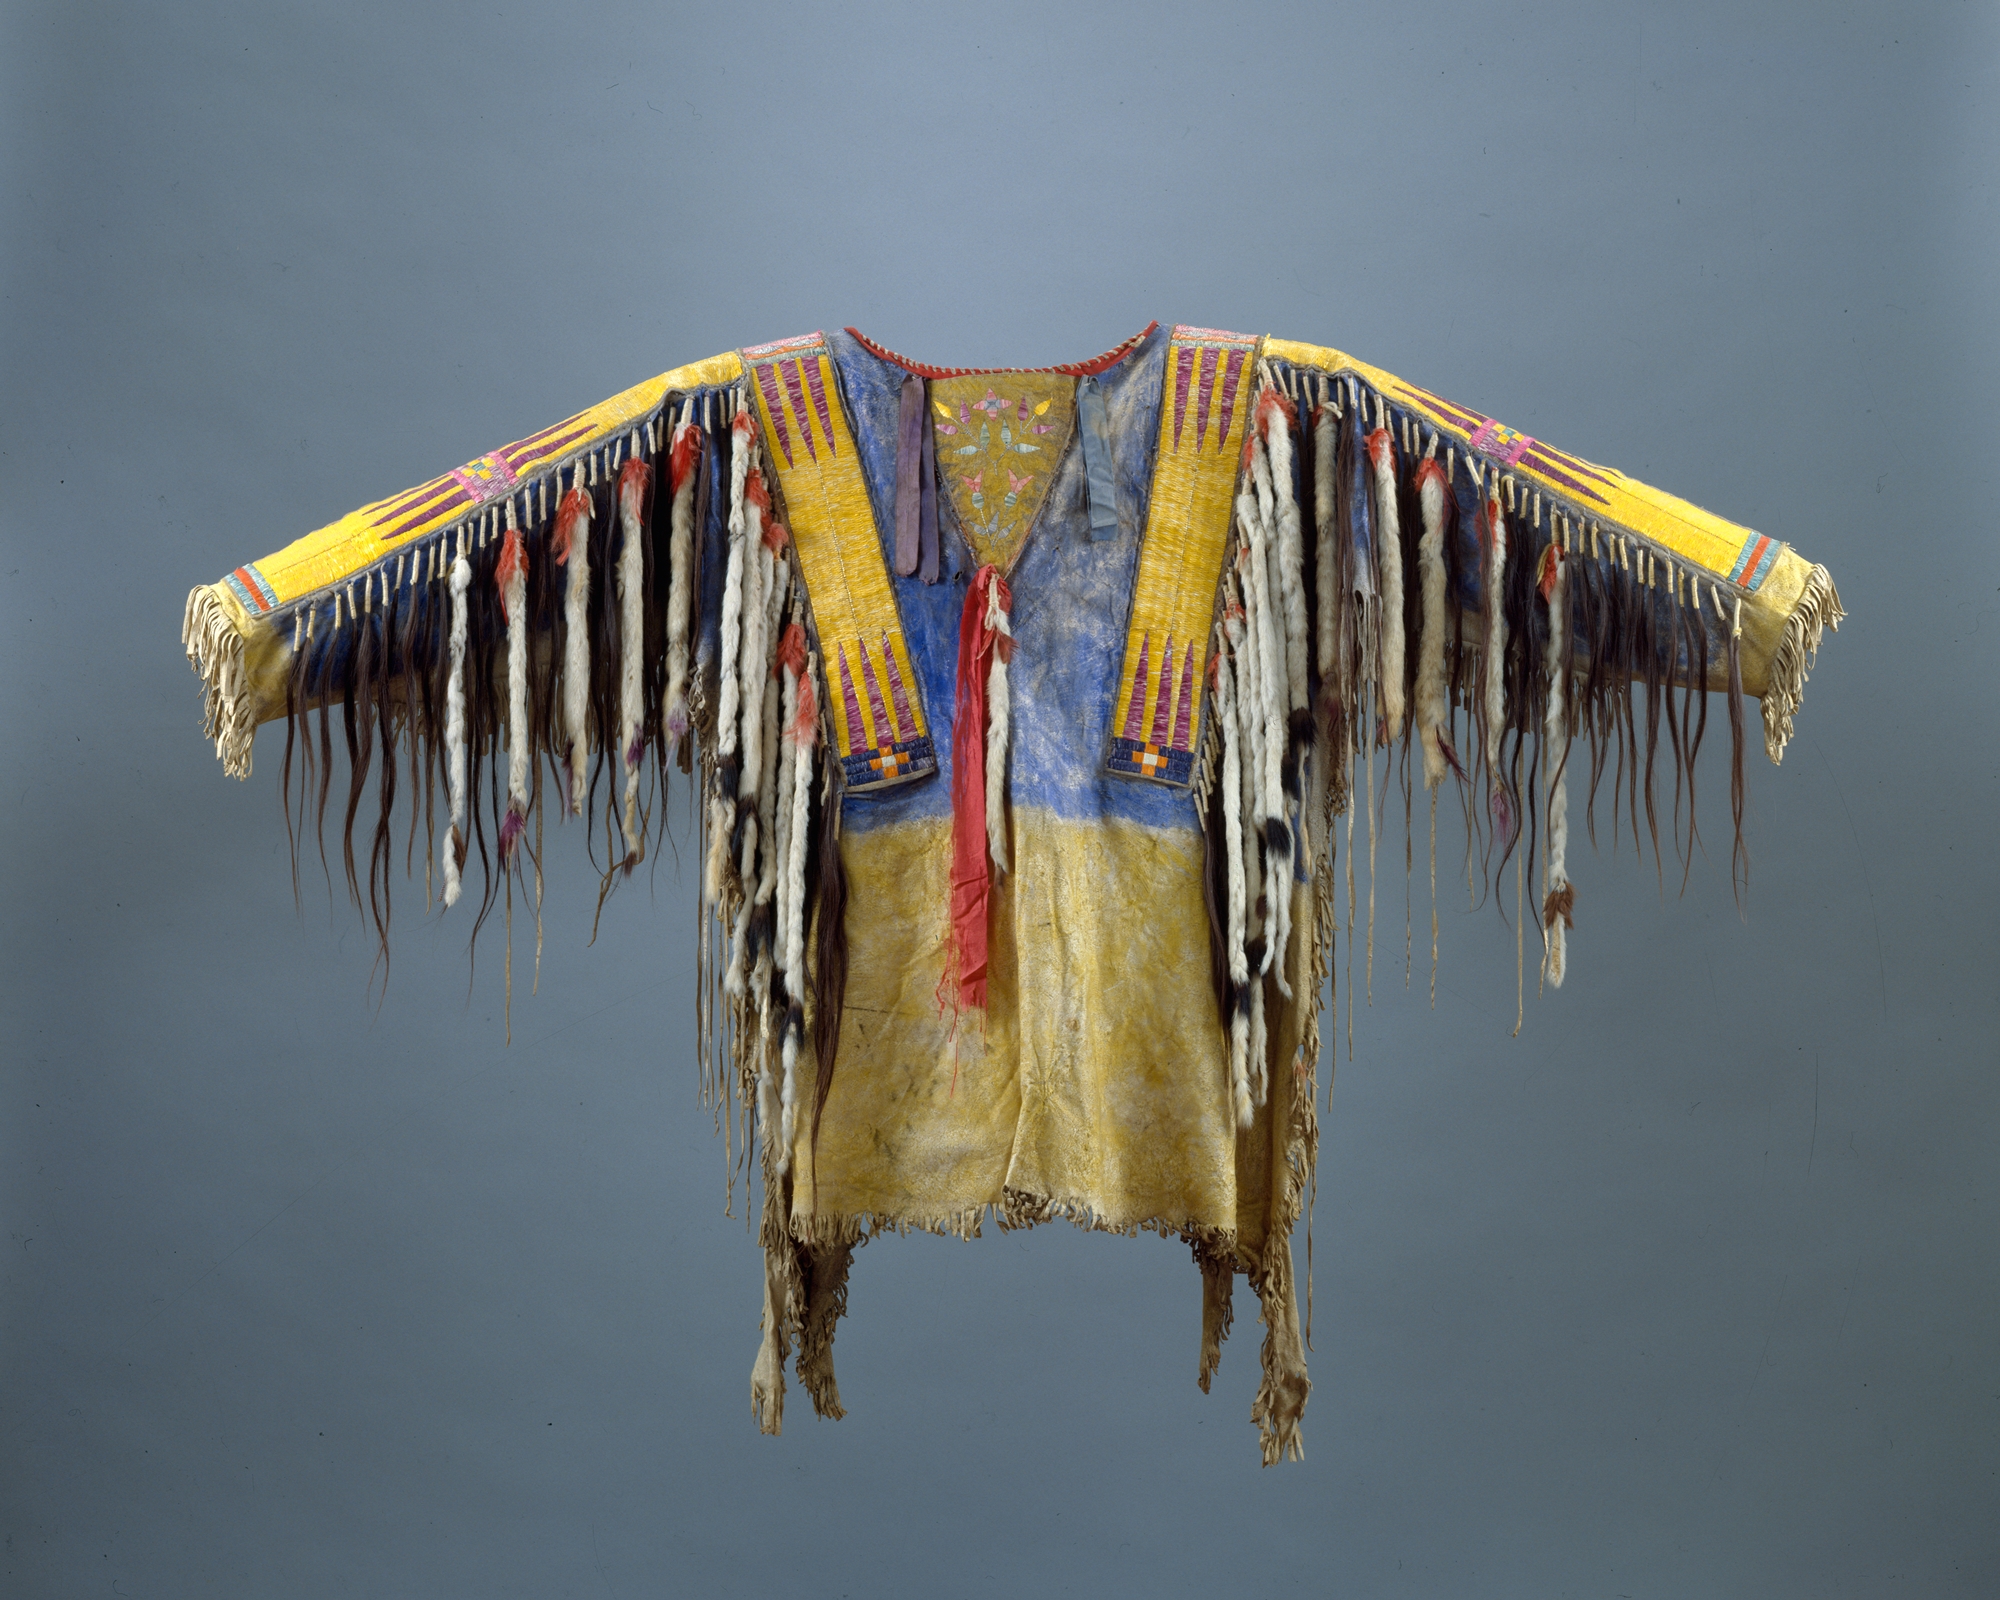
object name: shirt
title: Leadership Shirt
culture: arikara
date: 1860-1865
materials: feather, hair, pigment, silk, skin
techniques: tanning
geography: united states